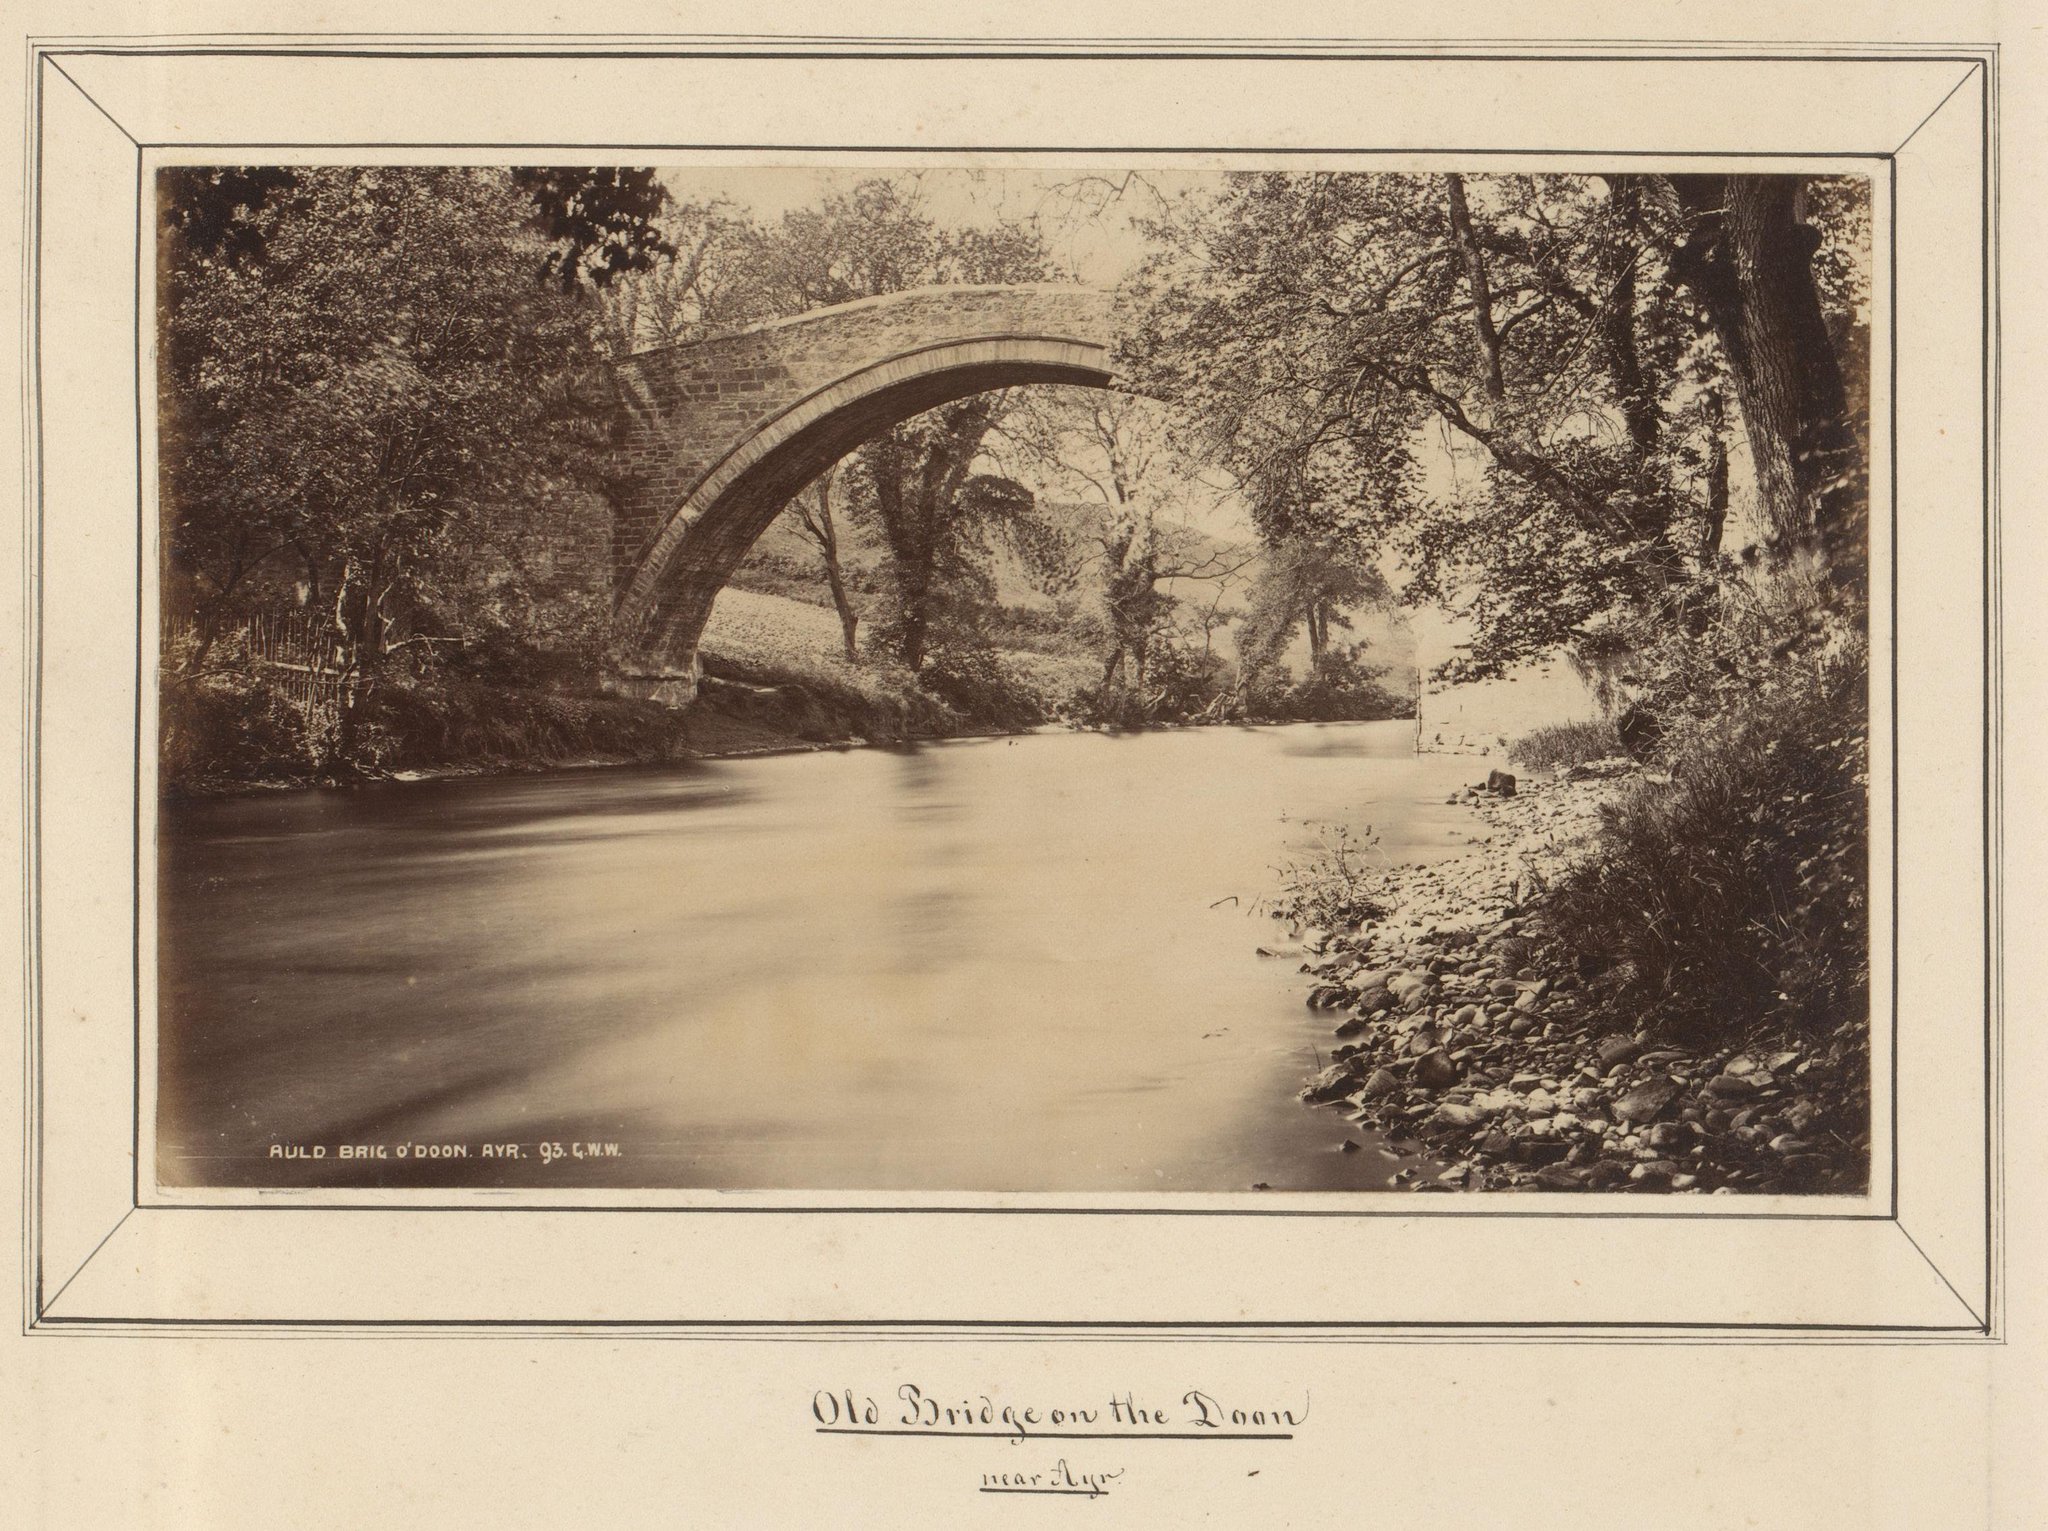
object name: photograph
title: Oude brug over de Doon, nabij Ayr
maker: george washington wilson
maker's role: publisher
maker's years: 1823-1893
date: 1870-1890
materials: paper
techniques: albumen print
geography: doon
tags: river, bridge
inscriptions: inscription: ‘Auld Brig o' Doon. Ayr. 93. G.W.W.’